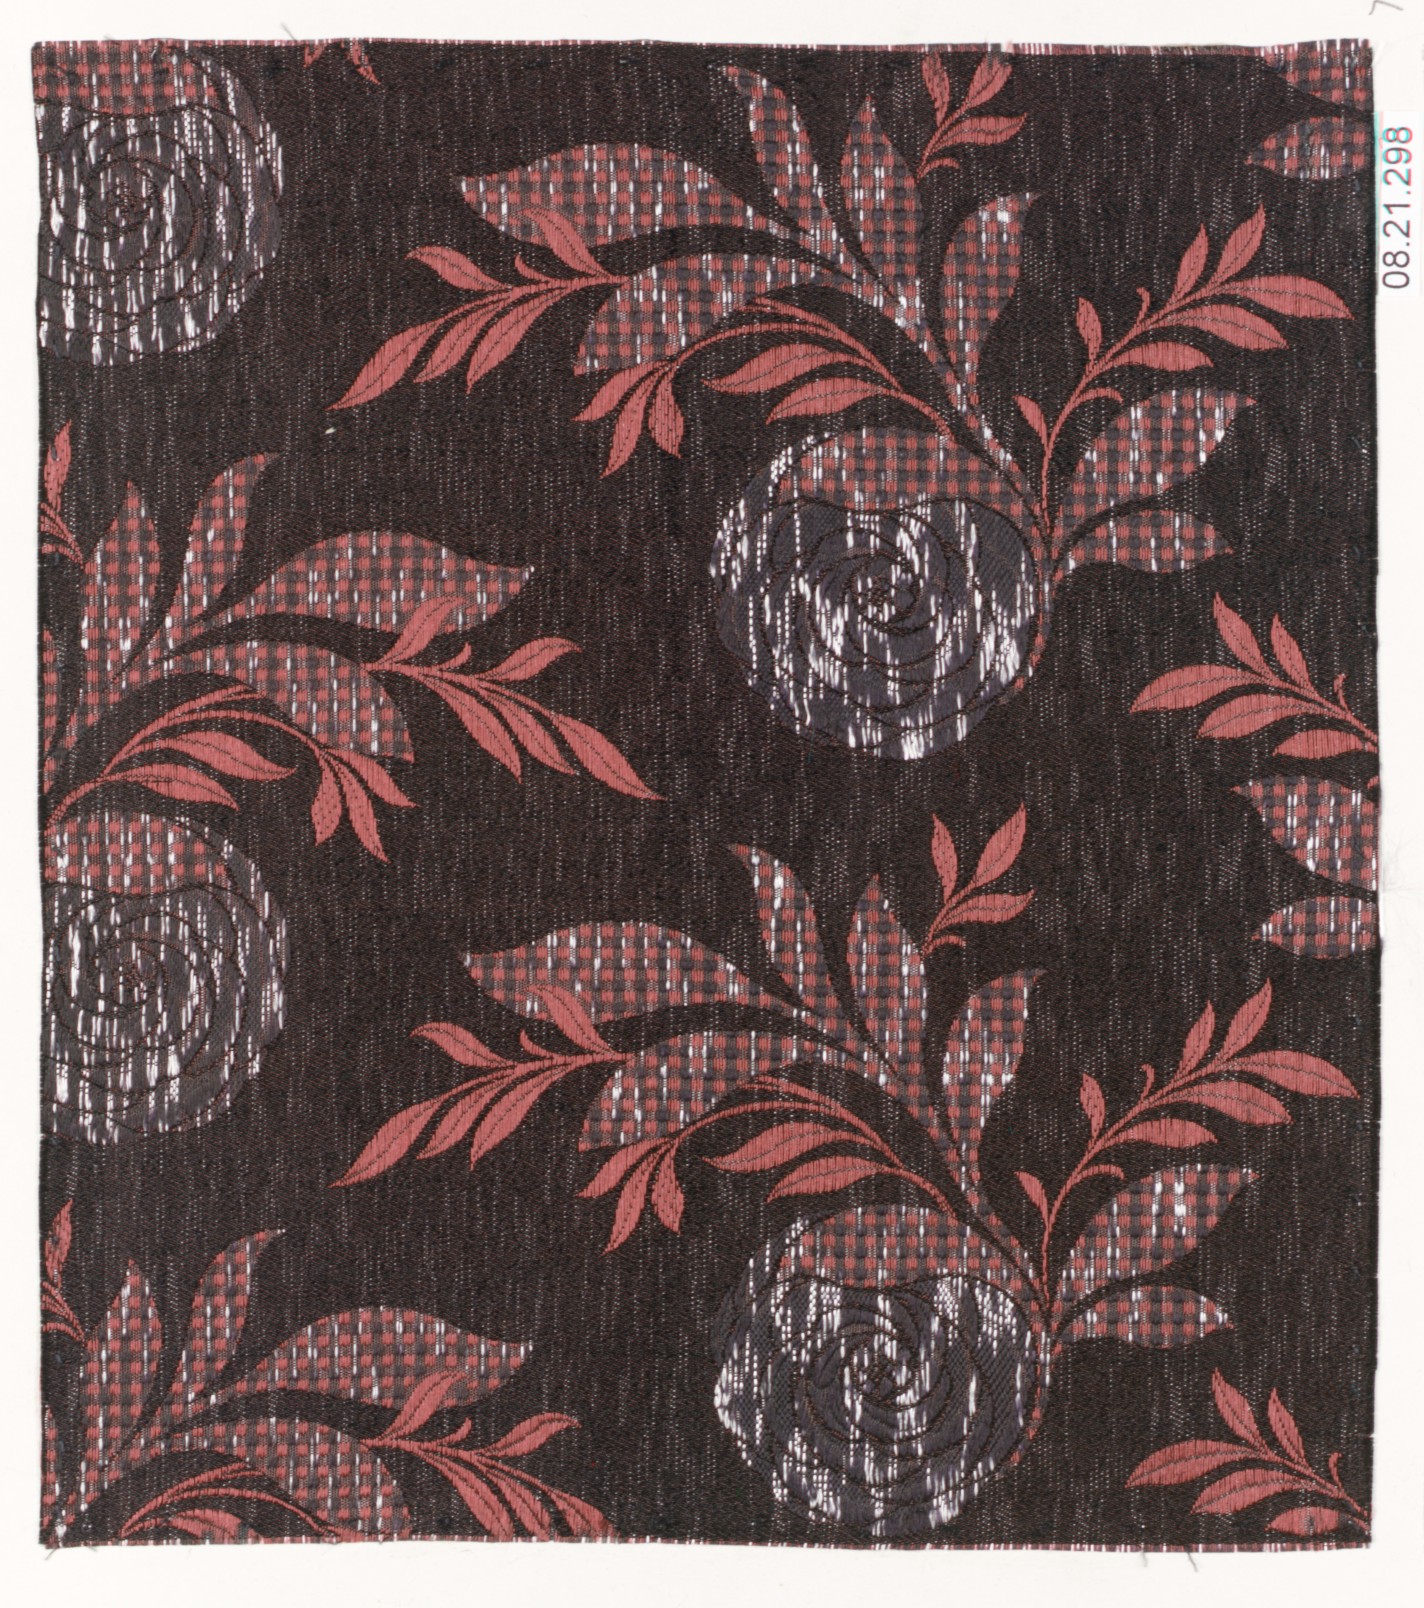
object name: textile sample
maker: Anonymous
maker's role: designer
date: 1900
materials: silk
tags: leaves